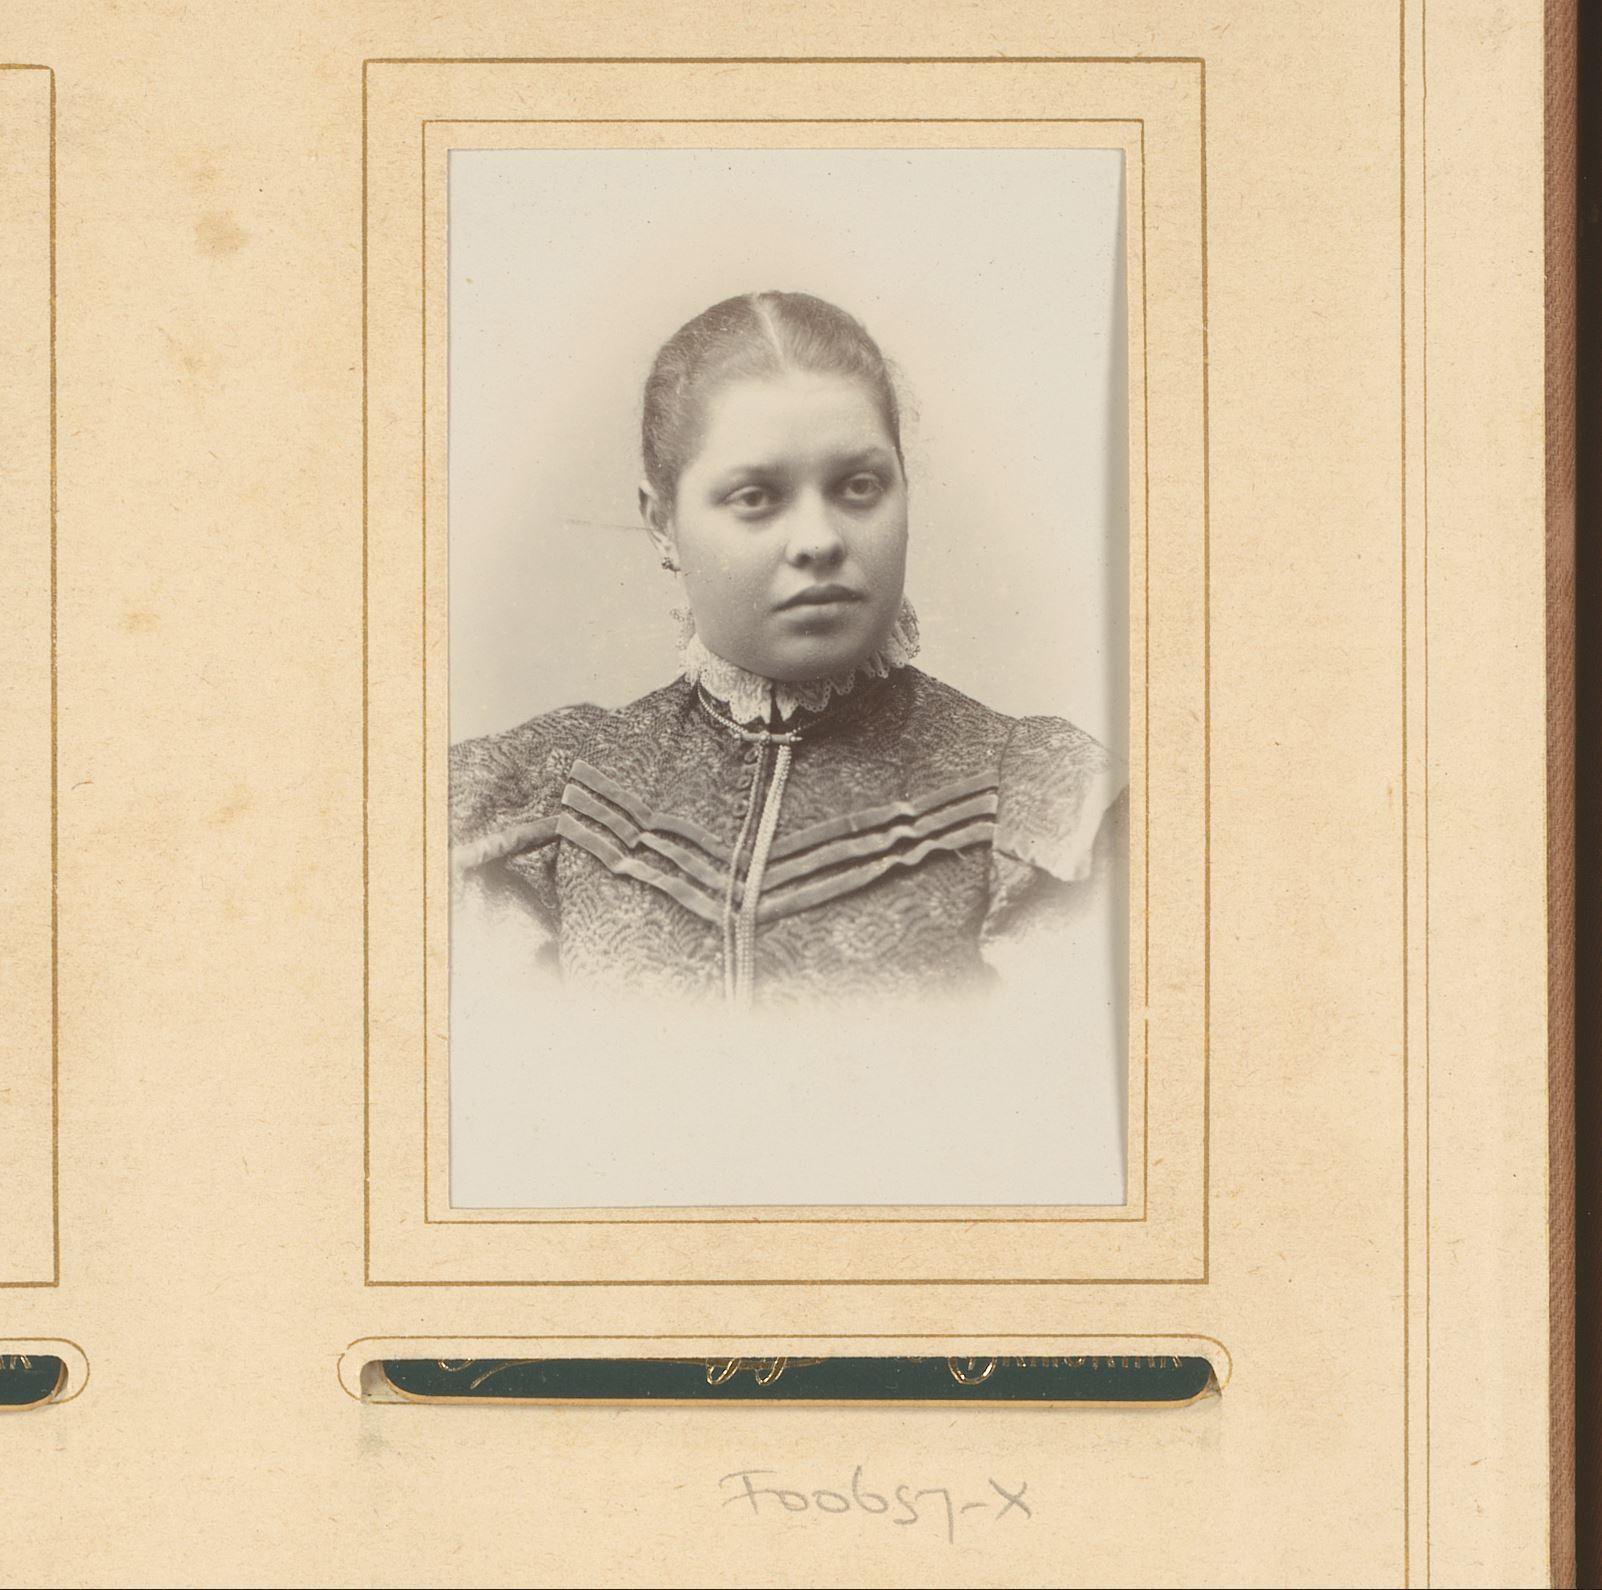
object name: carte de visite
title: Portret van een jonge vrouw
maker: alfred wragg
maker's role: fotograaf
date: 1882-1940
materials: cardboard, photographic support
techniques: gelatin silver print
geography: ormskirk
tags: adolescent, young woman, maiden, historical persons - bb - woman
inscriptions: inscription: ‘Alfred Wragg/ Burscough St/ Ormskirk’